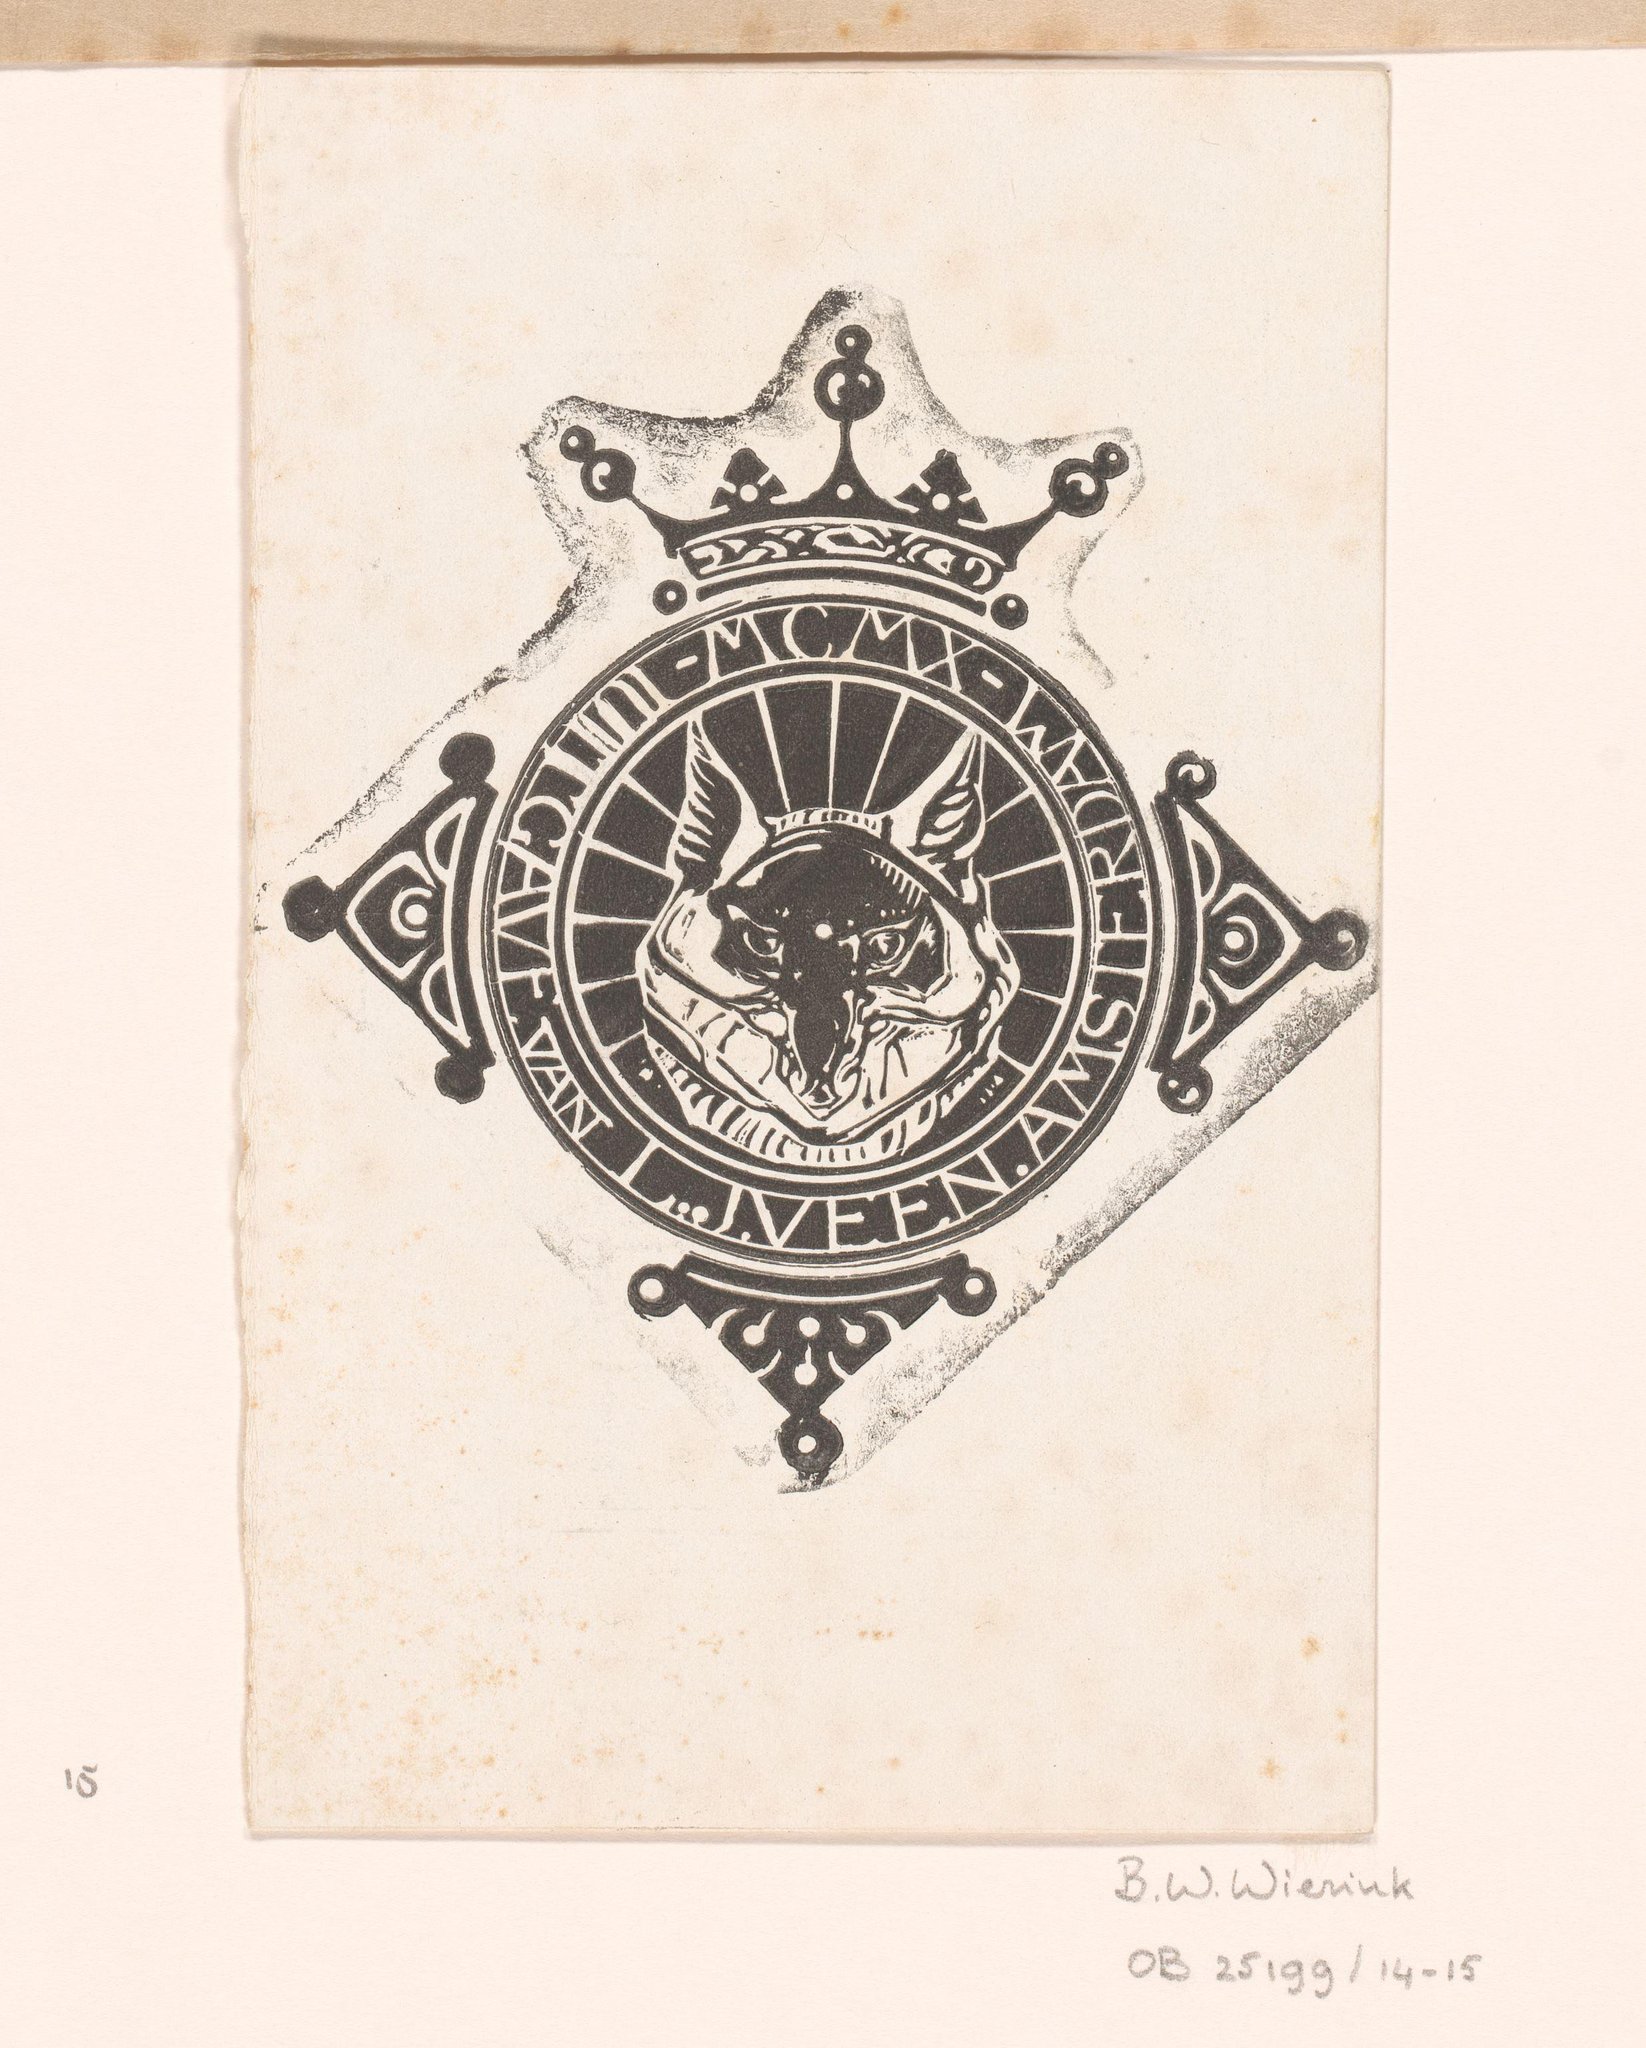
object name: boekillustratie ontwerp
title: Vignet voor uitgever L.J. Veen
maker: bernard willem wierink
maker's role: draughtsman, print maker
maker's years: 1856-1939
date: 1910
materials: paper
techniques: relief print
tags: device (trade-mark of printer or publisher), fable of reynard the fox, beasts of prey, predatory animals: fox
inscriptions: collector's mark: Lugt 2228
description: Ontwerp voor: Streuvels, Stijn (Frank Lateur). Reinaert de Vos naar verschillende uitgaven van het middeleeuwsche epos. Amsterdam: L.J. Veen, 1910. Deze prent is vermoedelijk een plaatsnede, ook al wordt in de literatuur veelal gesproken over een houtsnede. Voor zover Wierink zijn prenten in hoogdruk zelf nader heeft omschreven, heeft hij altijd de term 'plaatsnede' gebruikt.